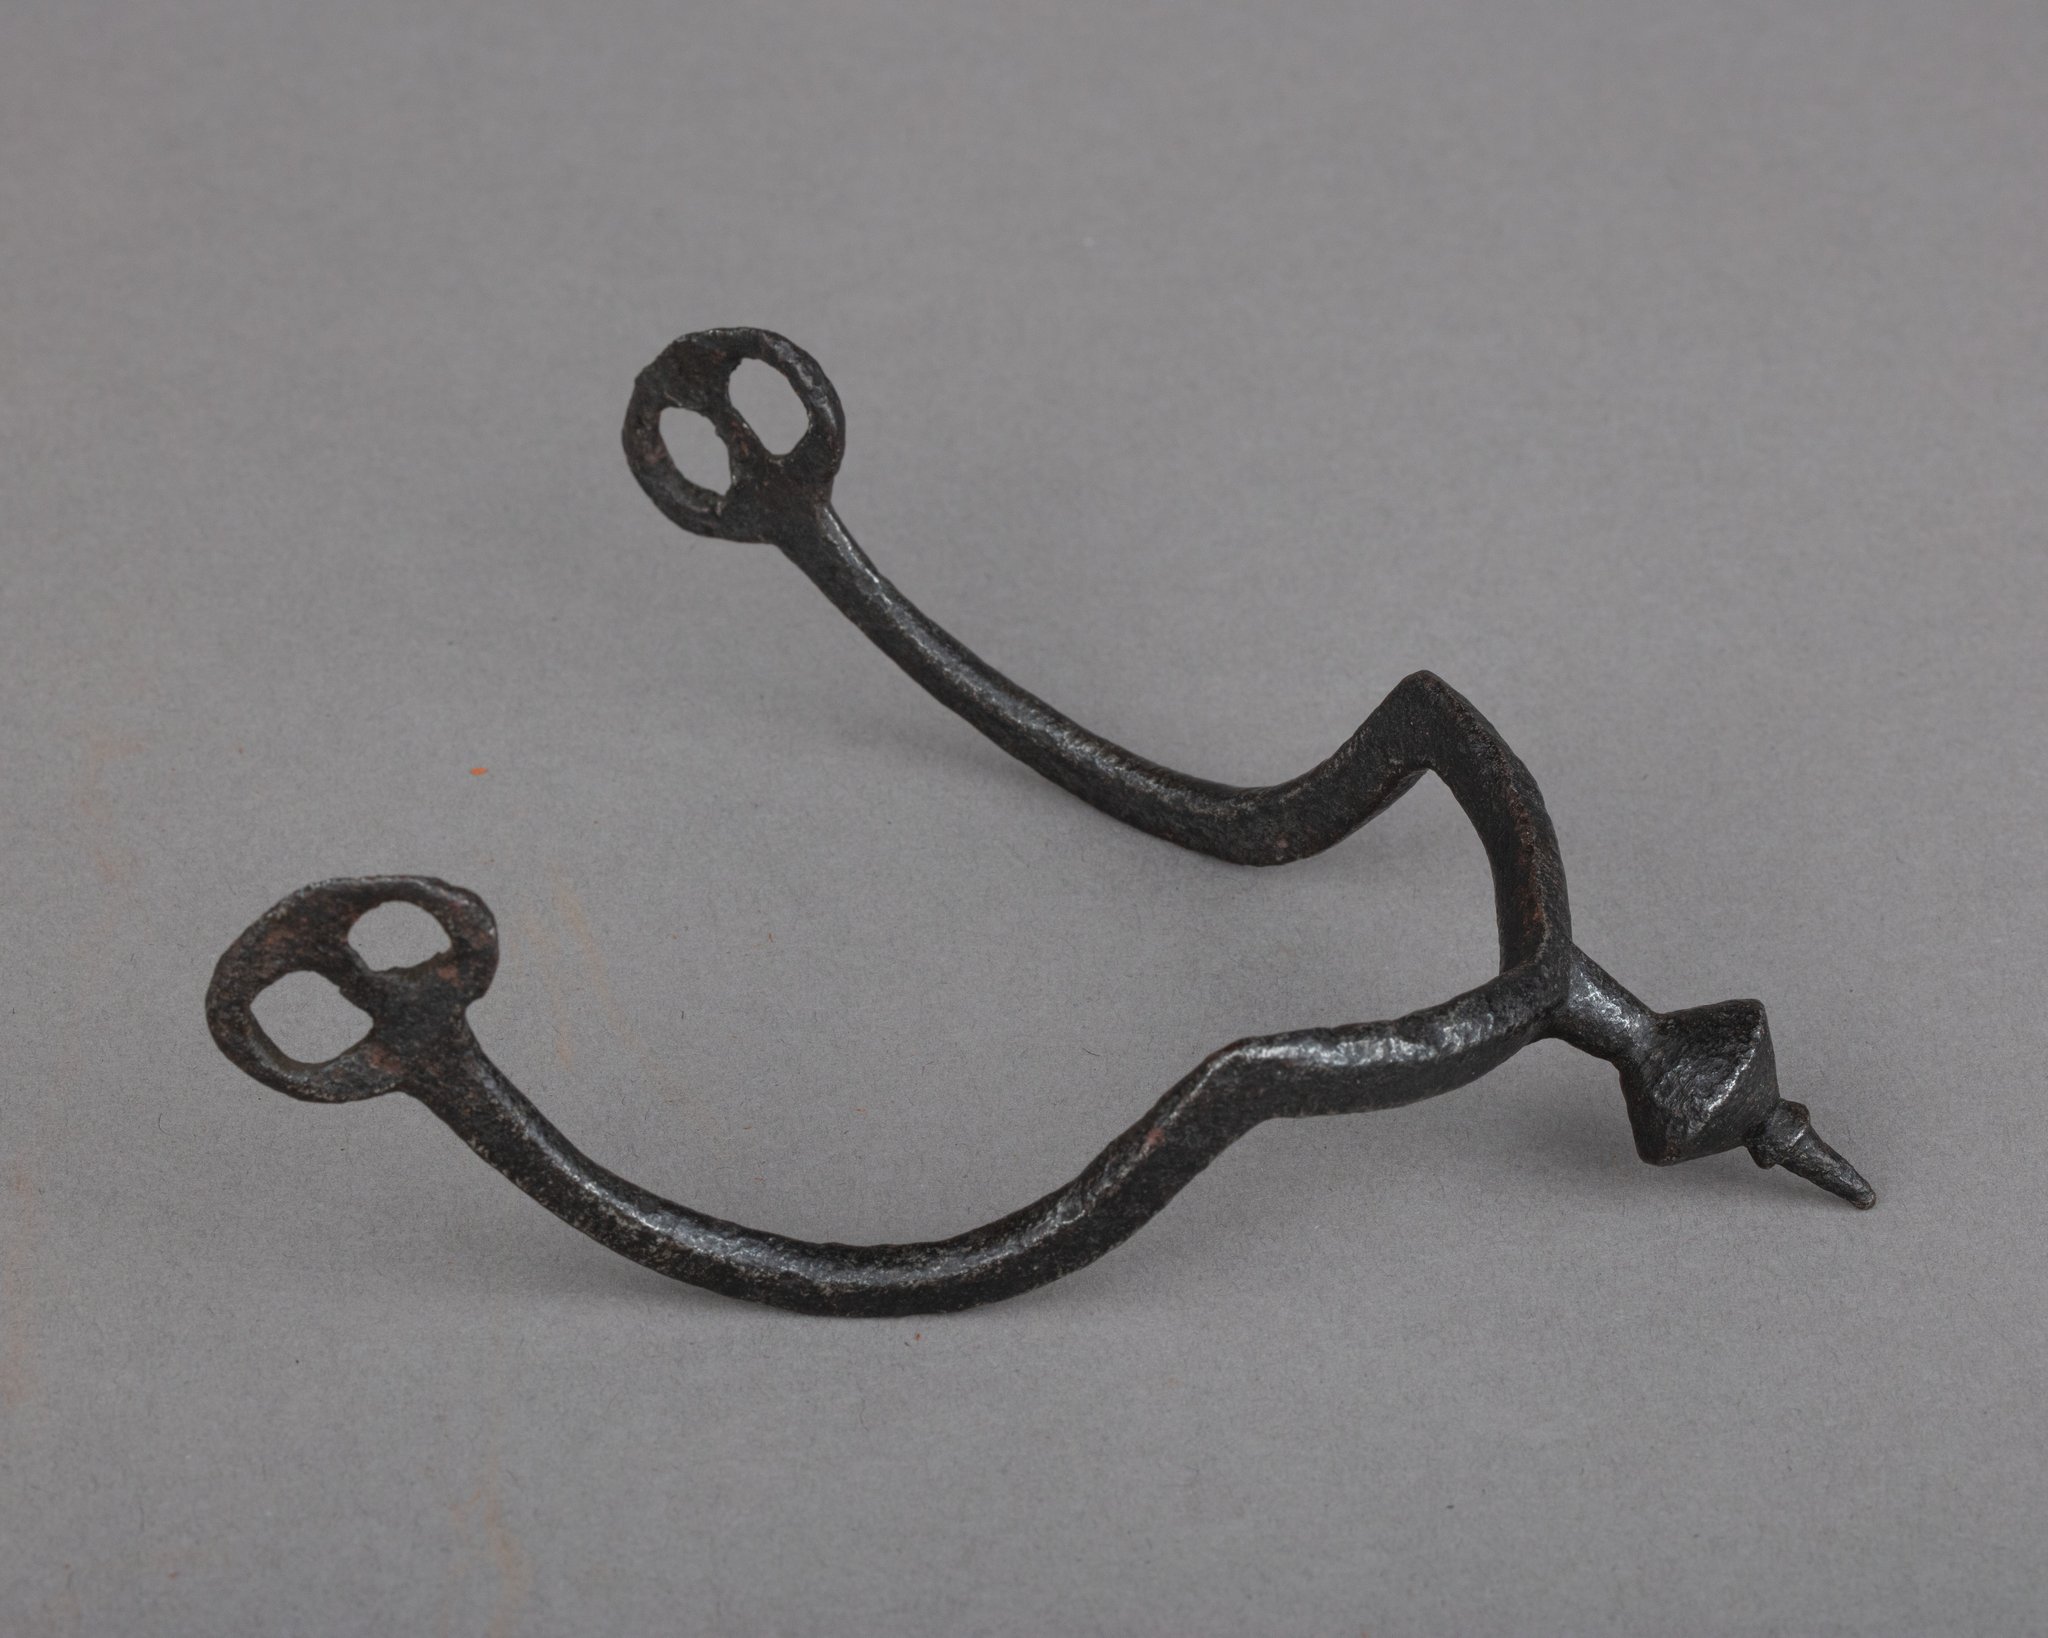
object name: spur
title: Prick Spur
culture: german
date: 1201-1300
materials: metal alloy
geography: germany